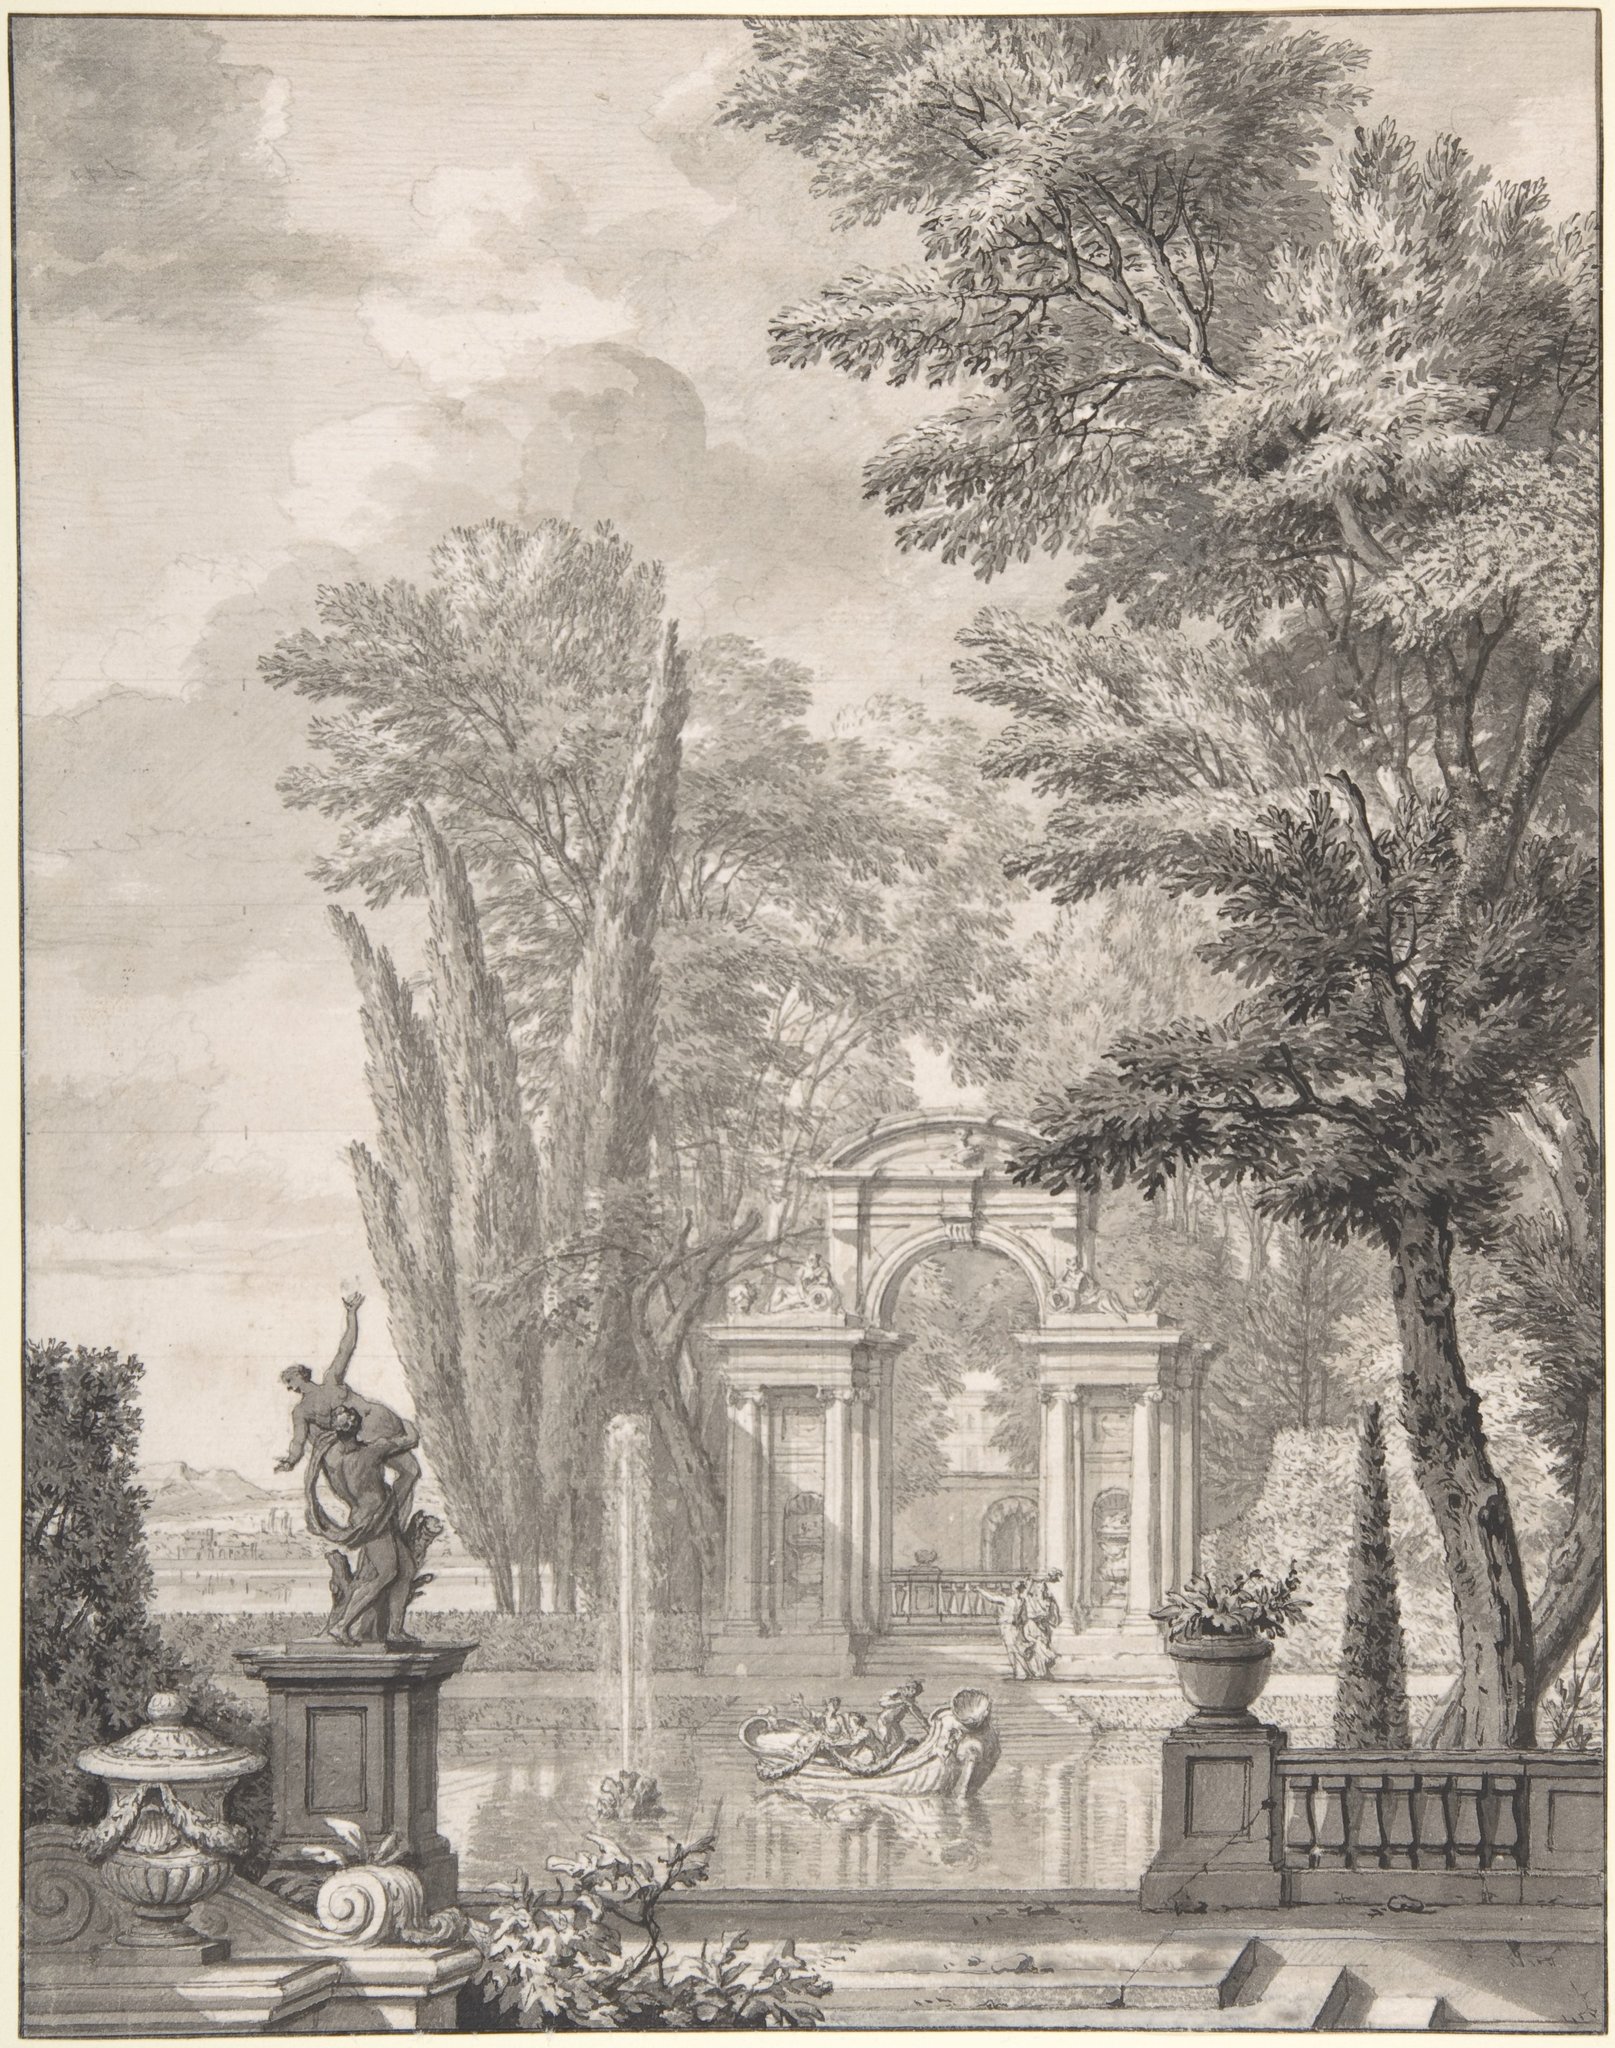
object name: drawing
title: Landscape with Architecture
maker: isaac de moucheron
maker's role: artist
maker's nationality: dutch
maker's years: 1667-1744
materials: chalk, ink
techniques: brush, pen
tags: fountains,landscapes,boats